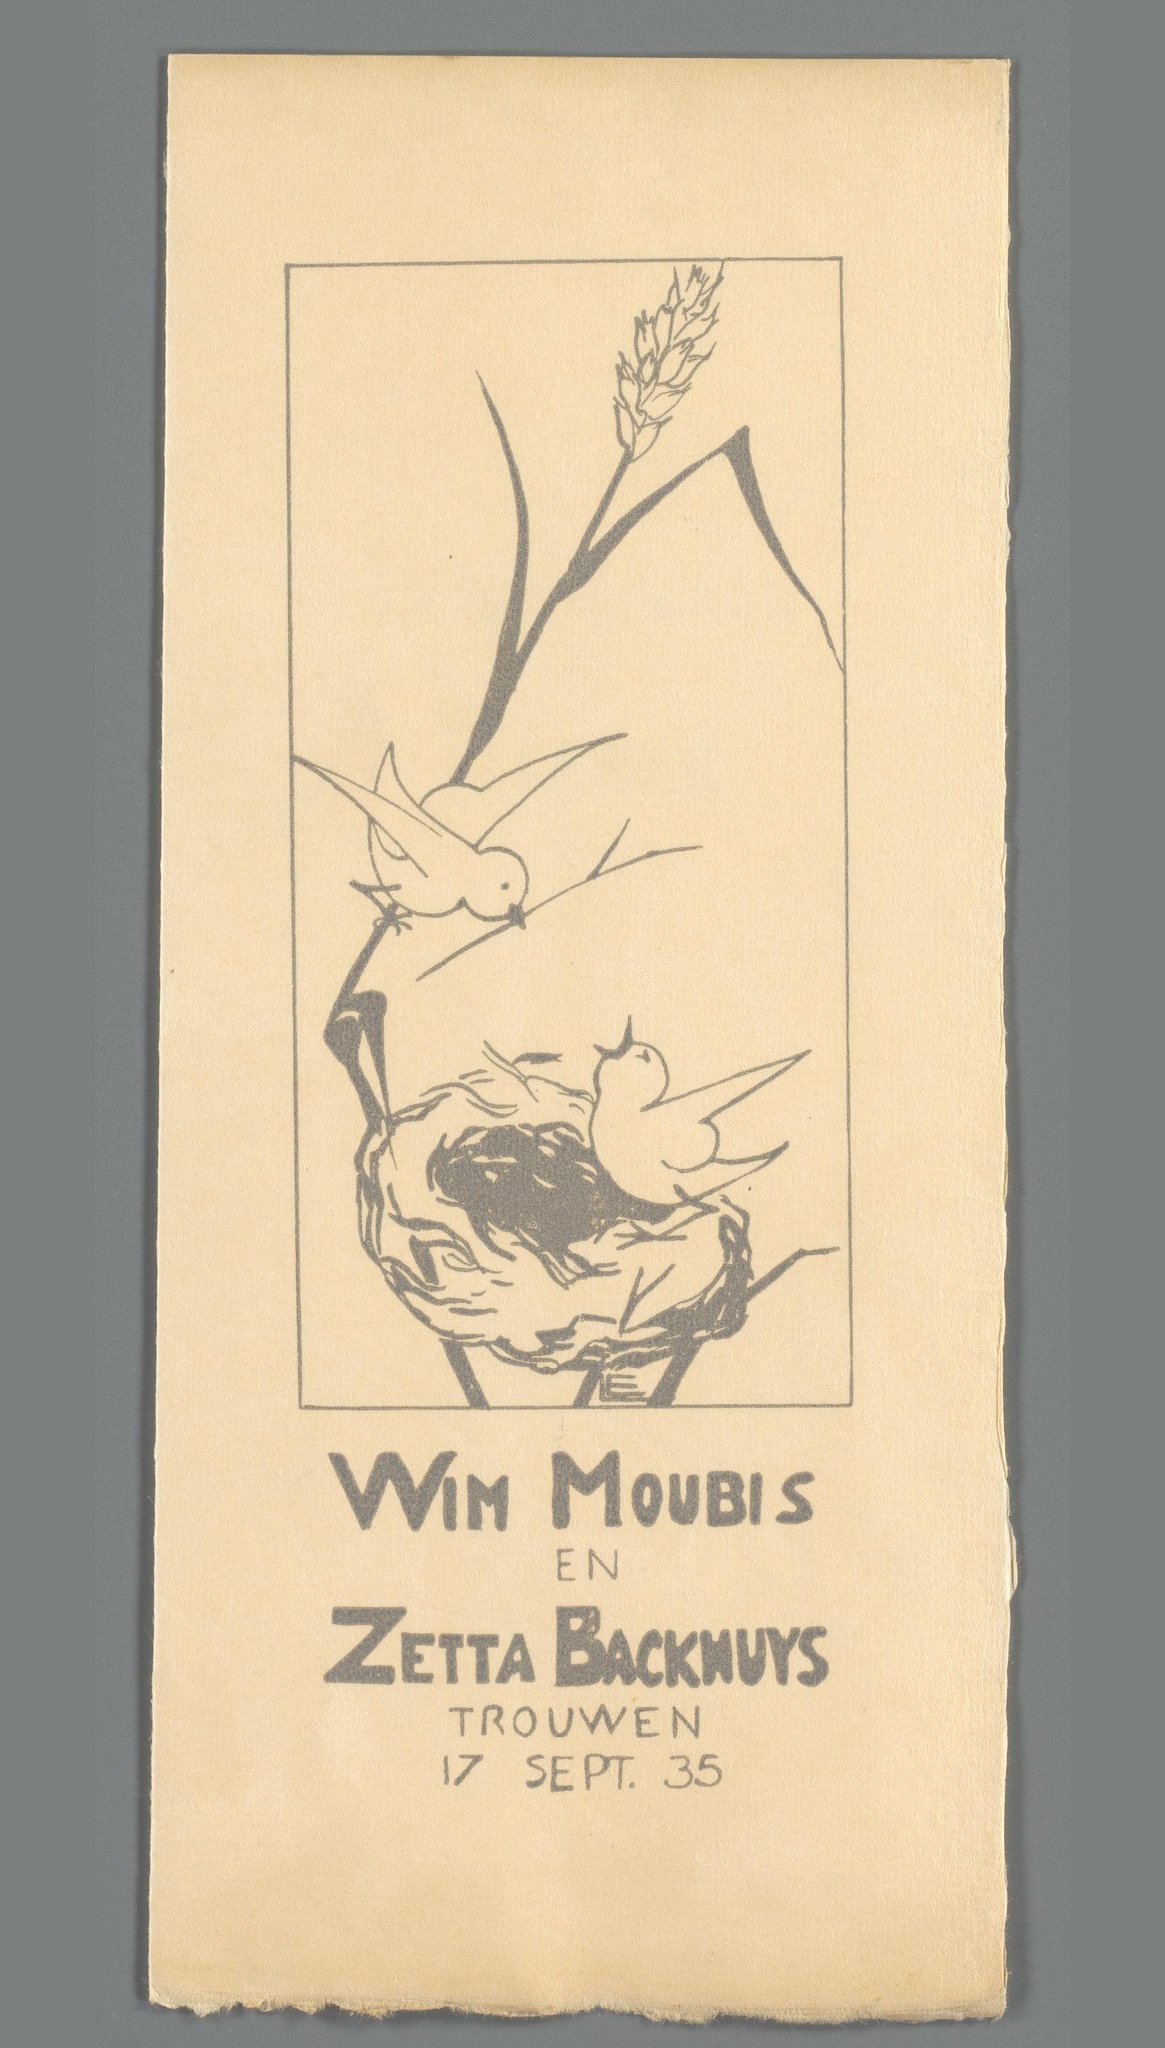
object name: wedding announcement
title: Huwelijksaankondiging van Wim Moubis en Zetta Backhuys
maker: Anonymous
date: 1935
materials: paper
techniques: printing block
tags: birds, betrothal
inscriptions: date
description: Twee vogels bij een nest in aanbouw. Daaronder: 'Wim Moubis en Zetta Backhuys trouwen 17 sept. 35'. Binnenin het nieuwe adres waar het stel gaat wonen.